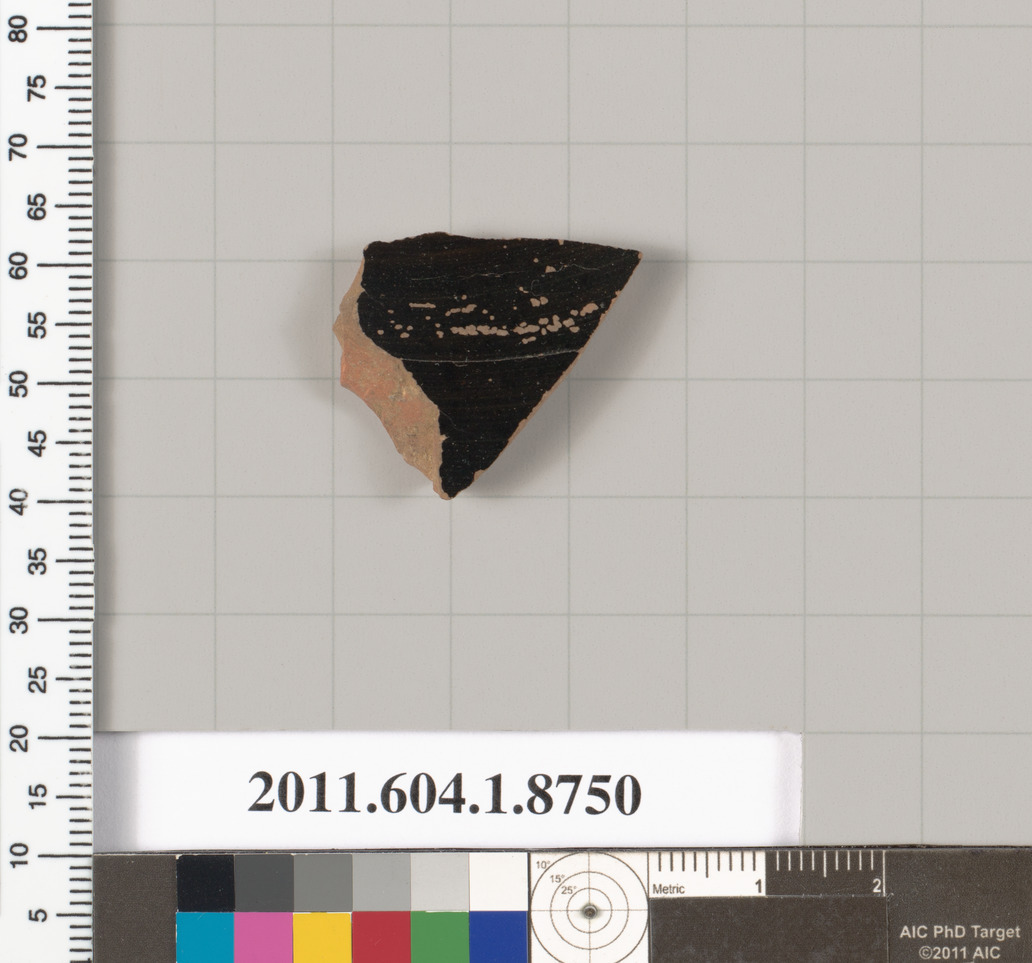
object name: kylix fragment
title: Terracotta fragment of a kylix (drinking cup)?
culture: greek, attic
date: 500-501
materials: terracotta